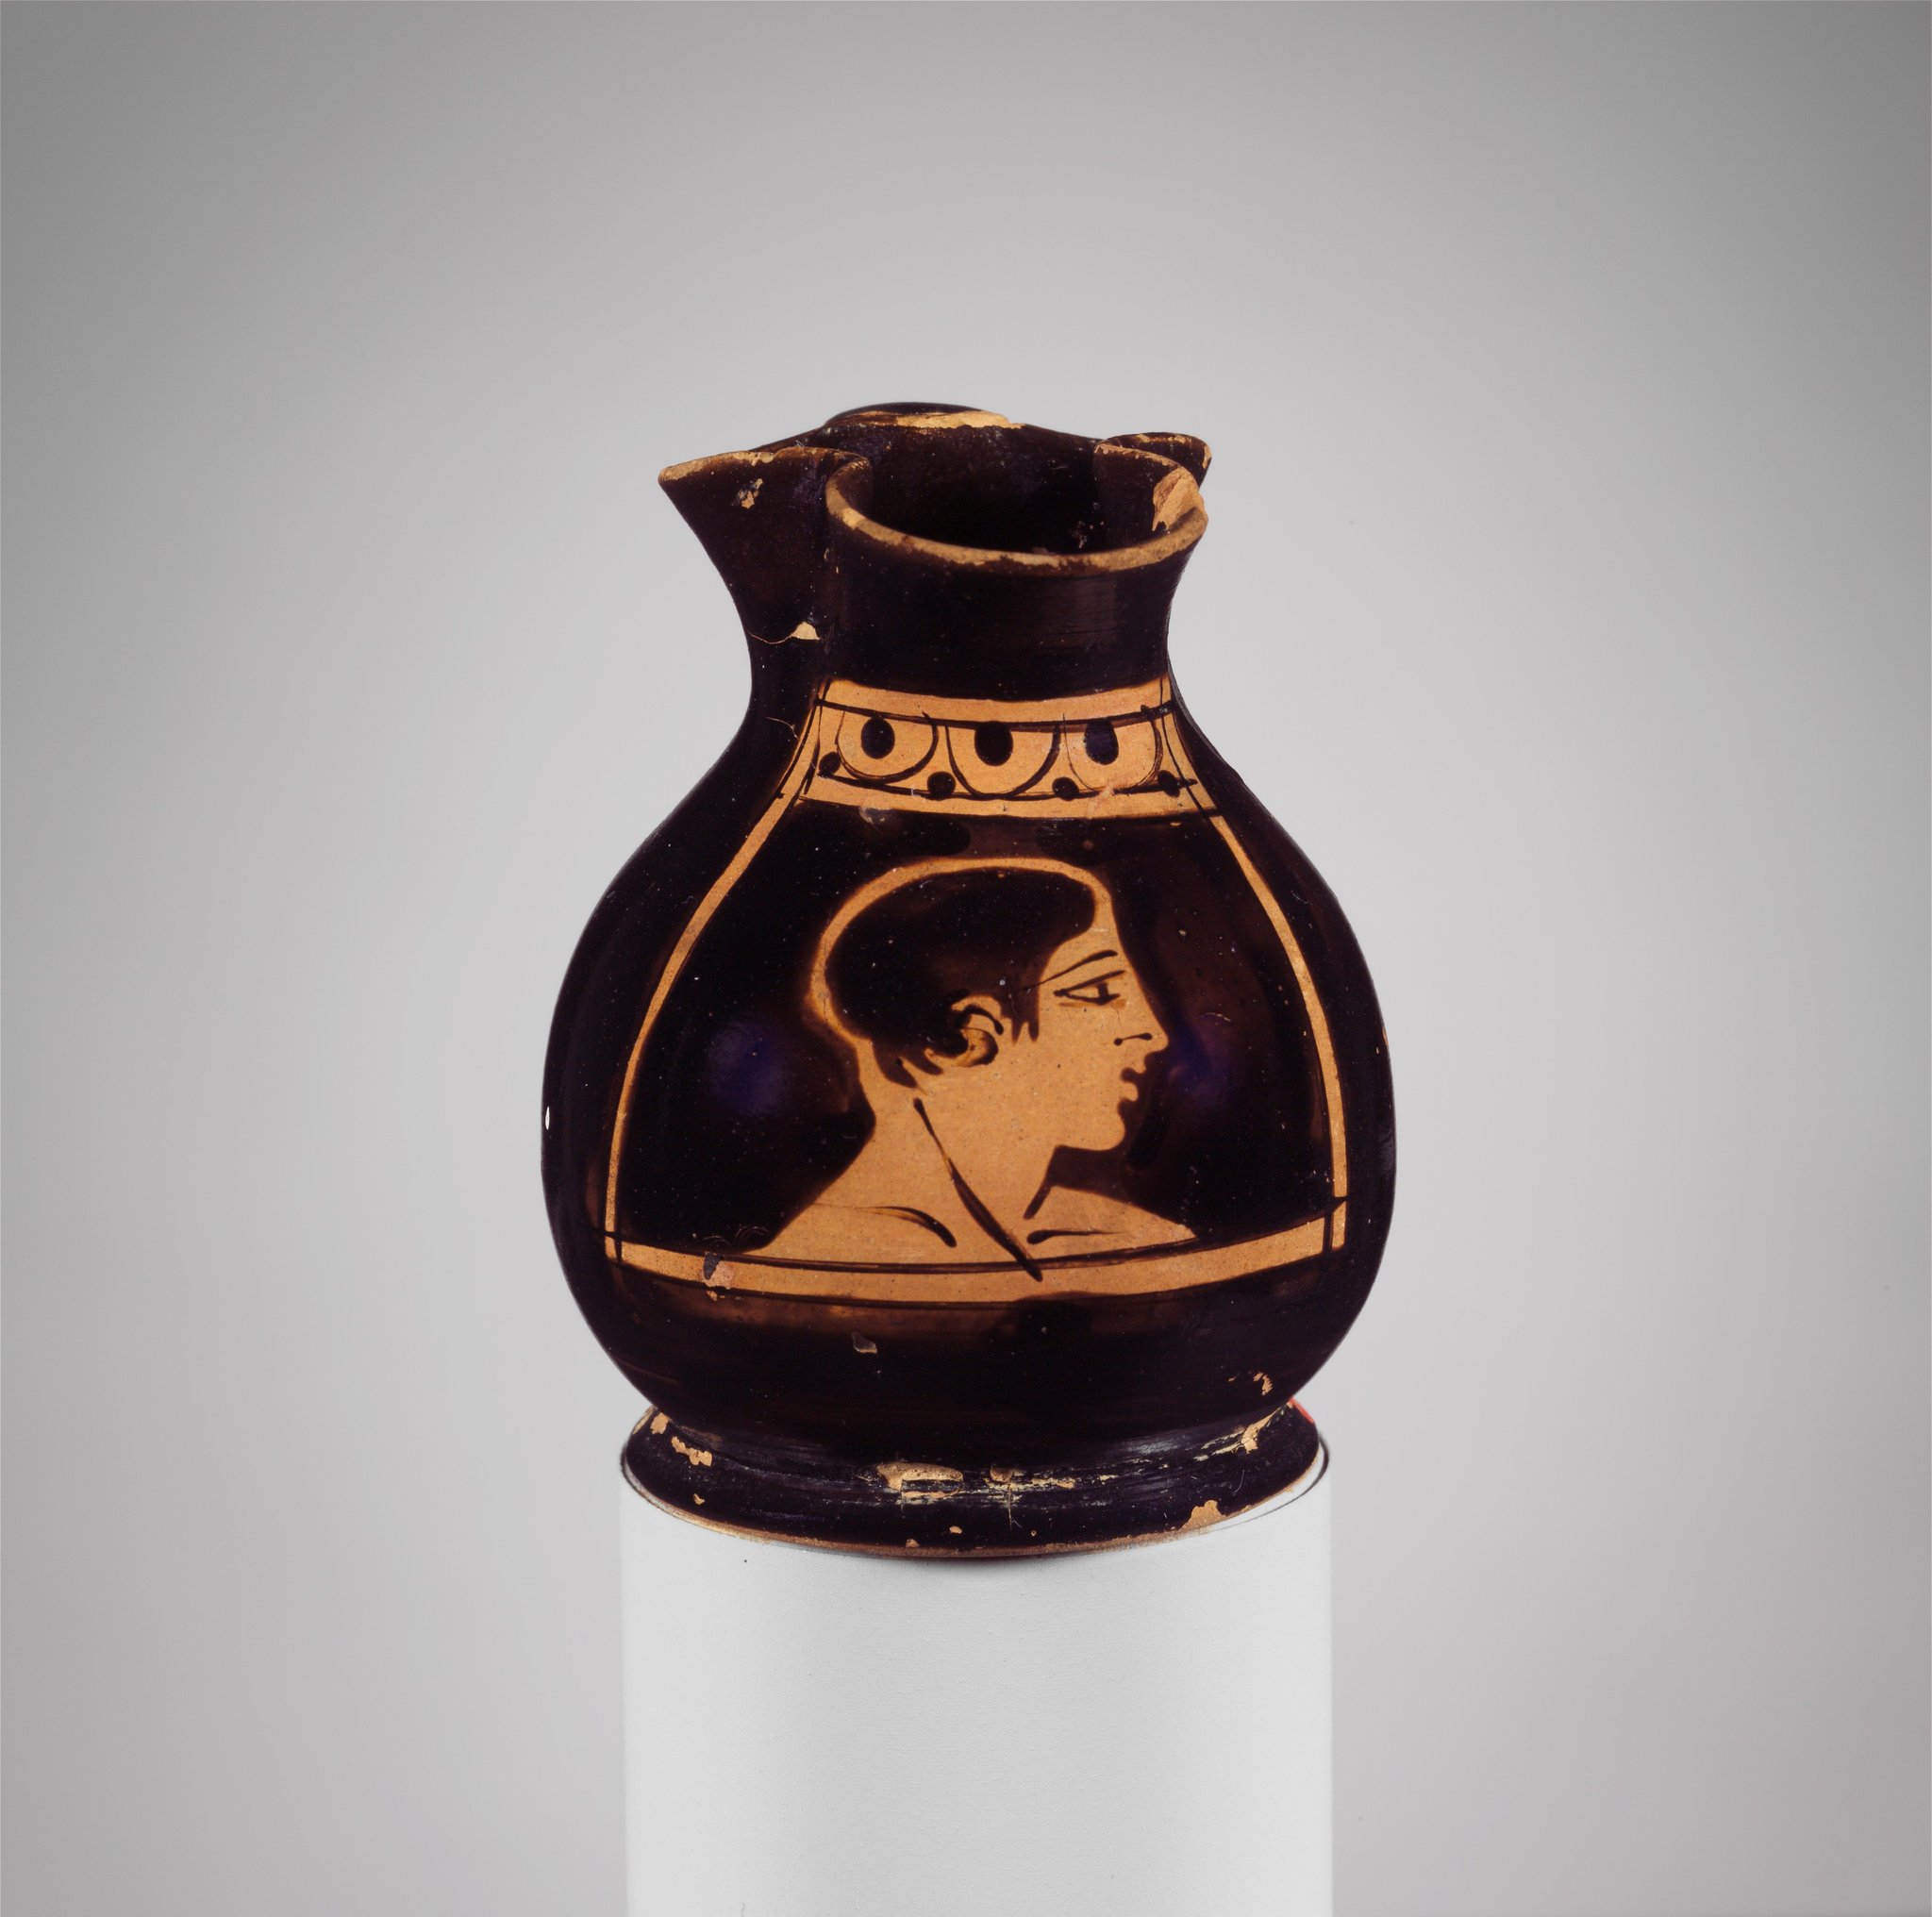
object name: oinochoe, chou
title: Terracotta oinochoe: chous (jug)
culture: greek, attic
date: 467-435 BCE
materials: terracotta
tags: human figures,heads